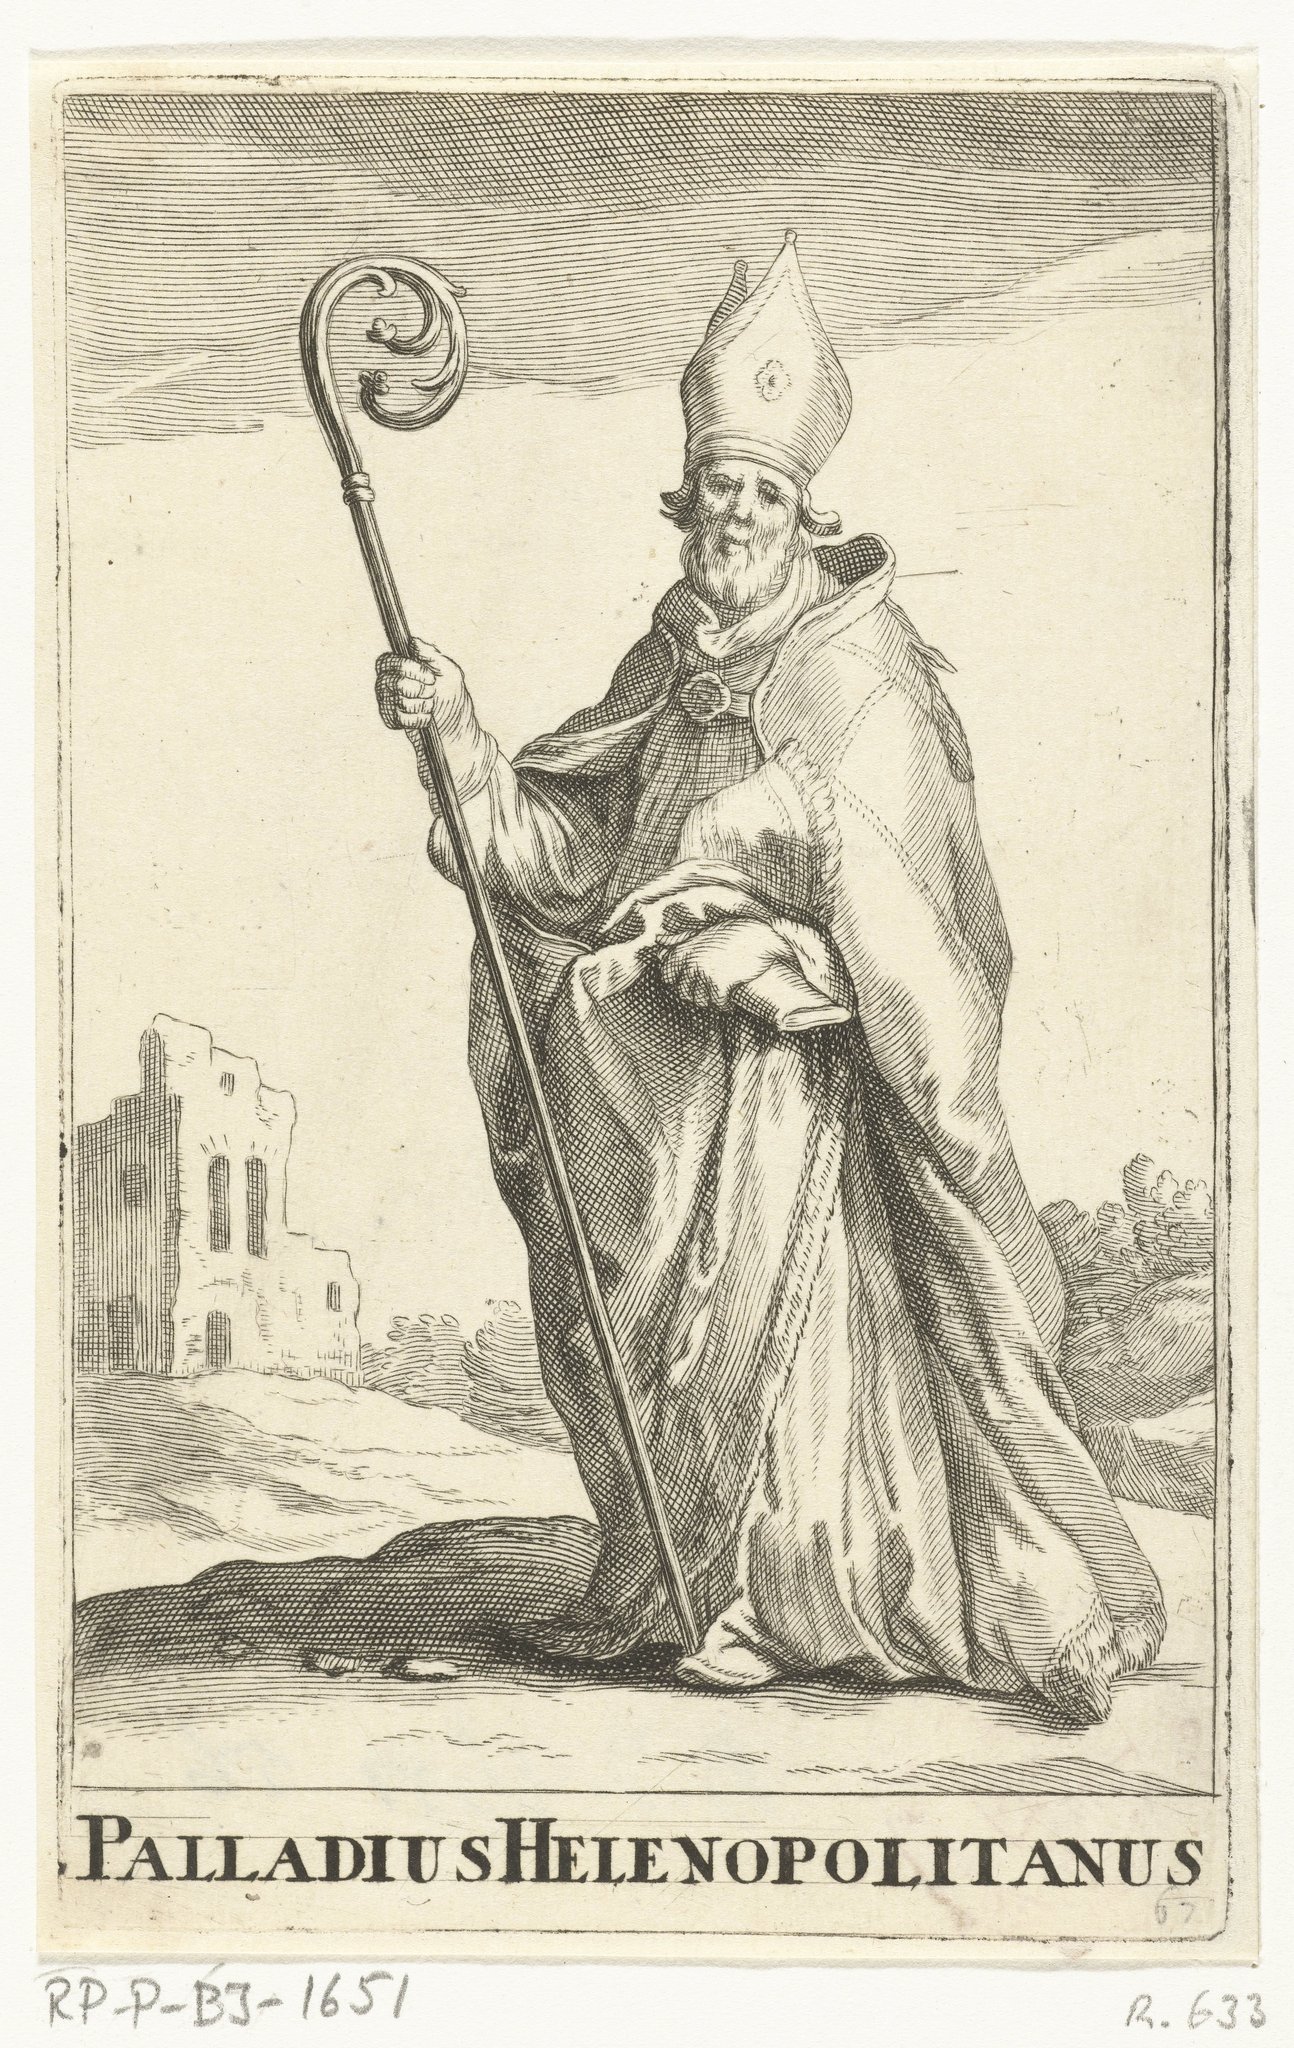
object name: print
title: Palladius Helenopolitanus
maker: frederick bloemaert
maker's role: print maker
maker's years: 1614-1669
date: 1636-1670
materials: paper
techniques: engraving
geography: utrecht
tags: male saints (with name)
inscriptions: number: ‘67’, collector's mark: Lugt 240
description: De heilige Palladius is afgebeeld als bisschop van Helenopolis met staf, mijter en boek. Prent uit een serie van 80 prenten en een titelprent met kluizenaars uit de 2e tot de 6e eeuw.